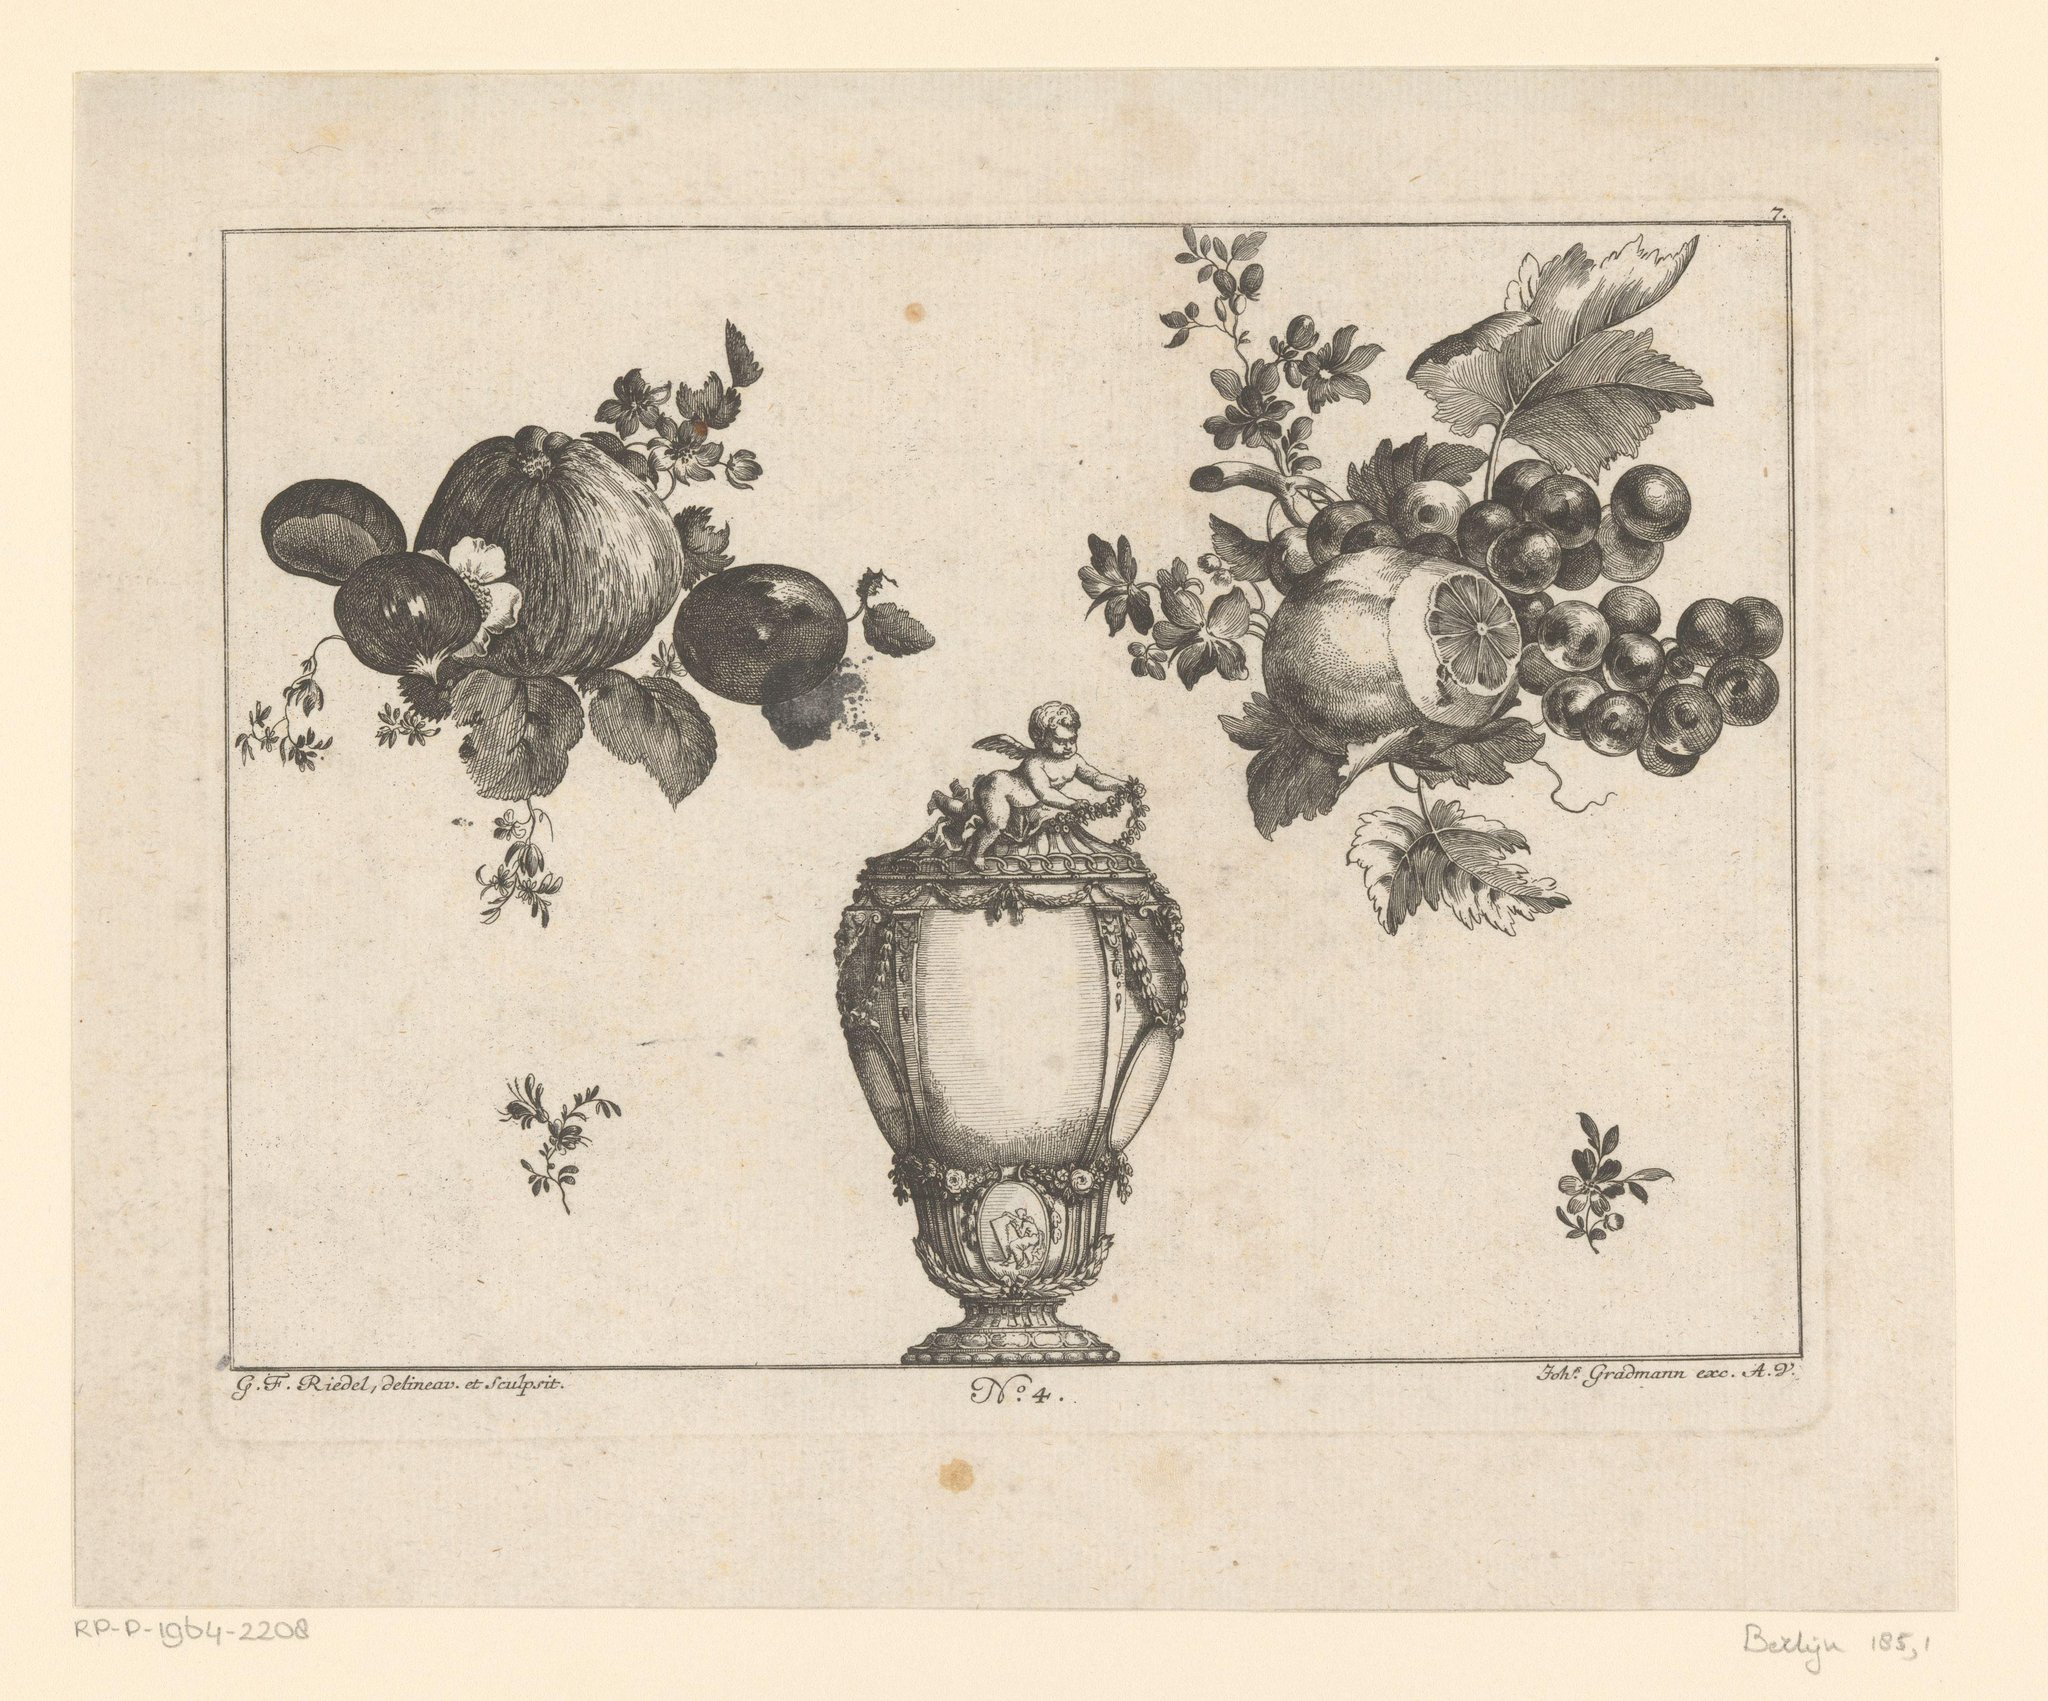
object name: ornament print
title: Samlung verschiedner Blumen, Früchte, gewohnlicher Zierathen (...)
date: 1778-1779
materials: paper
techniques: etching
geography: augsburg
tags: vase ~ ornament, fruits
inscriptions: collector's mark: Lugt 2228, collector's mark: Lugt 2760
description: Een geornamenteerde vaas met midden onder een gevleugelde putto en diverse vruchten en bloemen links- en rechts boven. Uitgeversnummer 4.